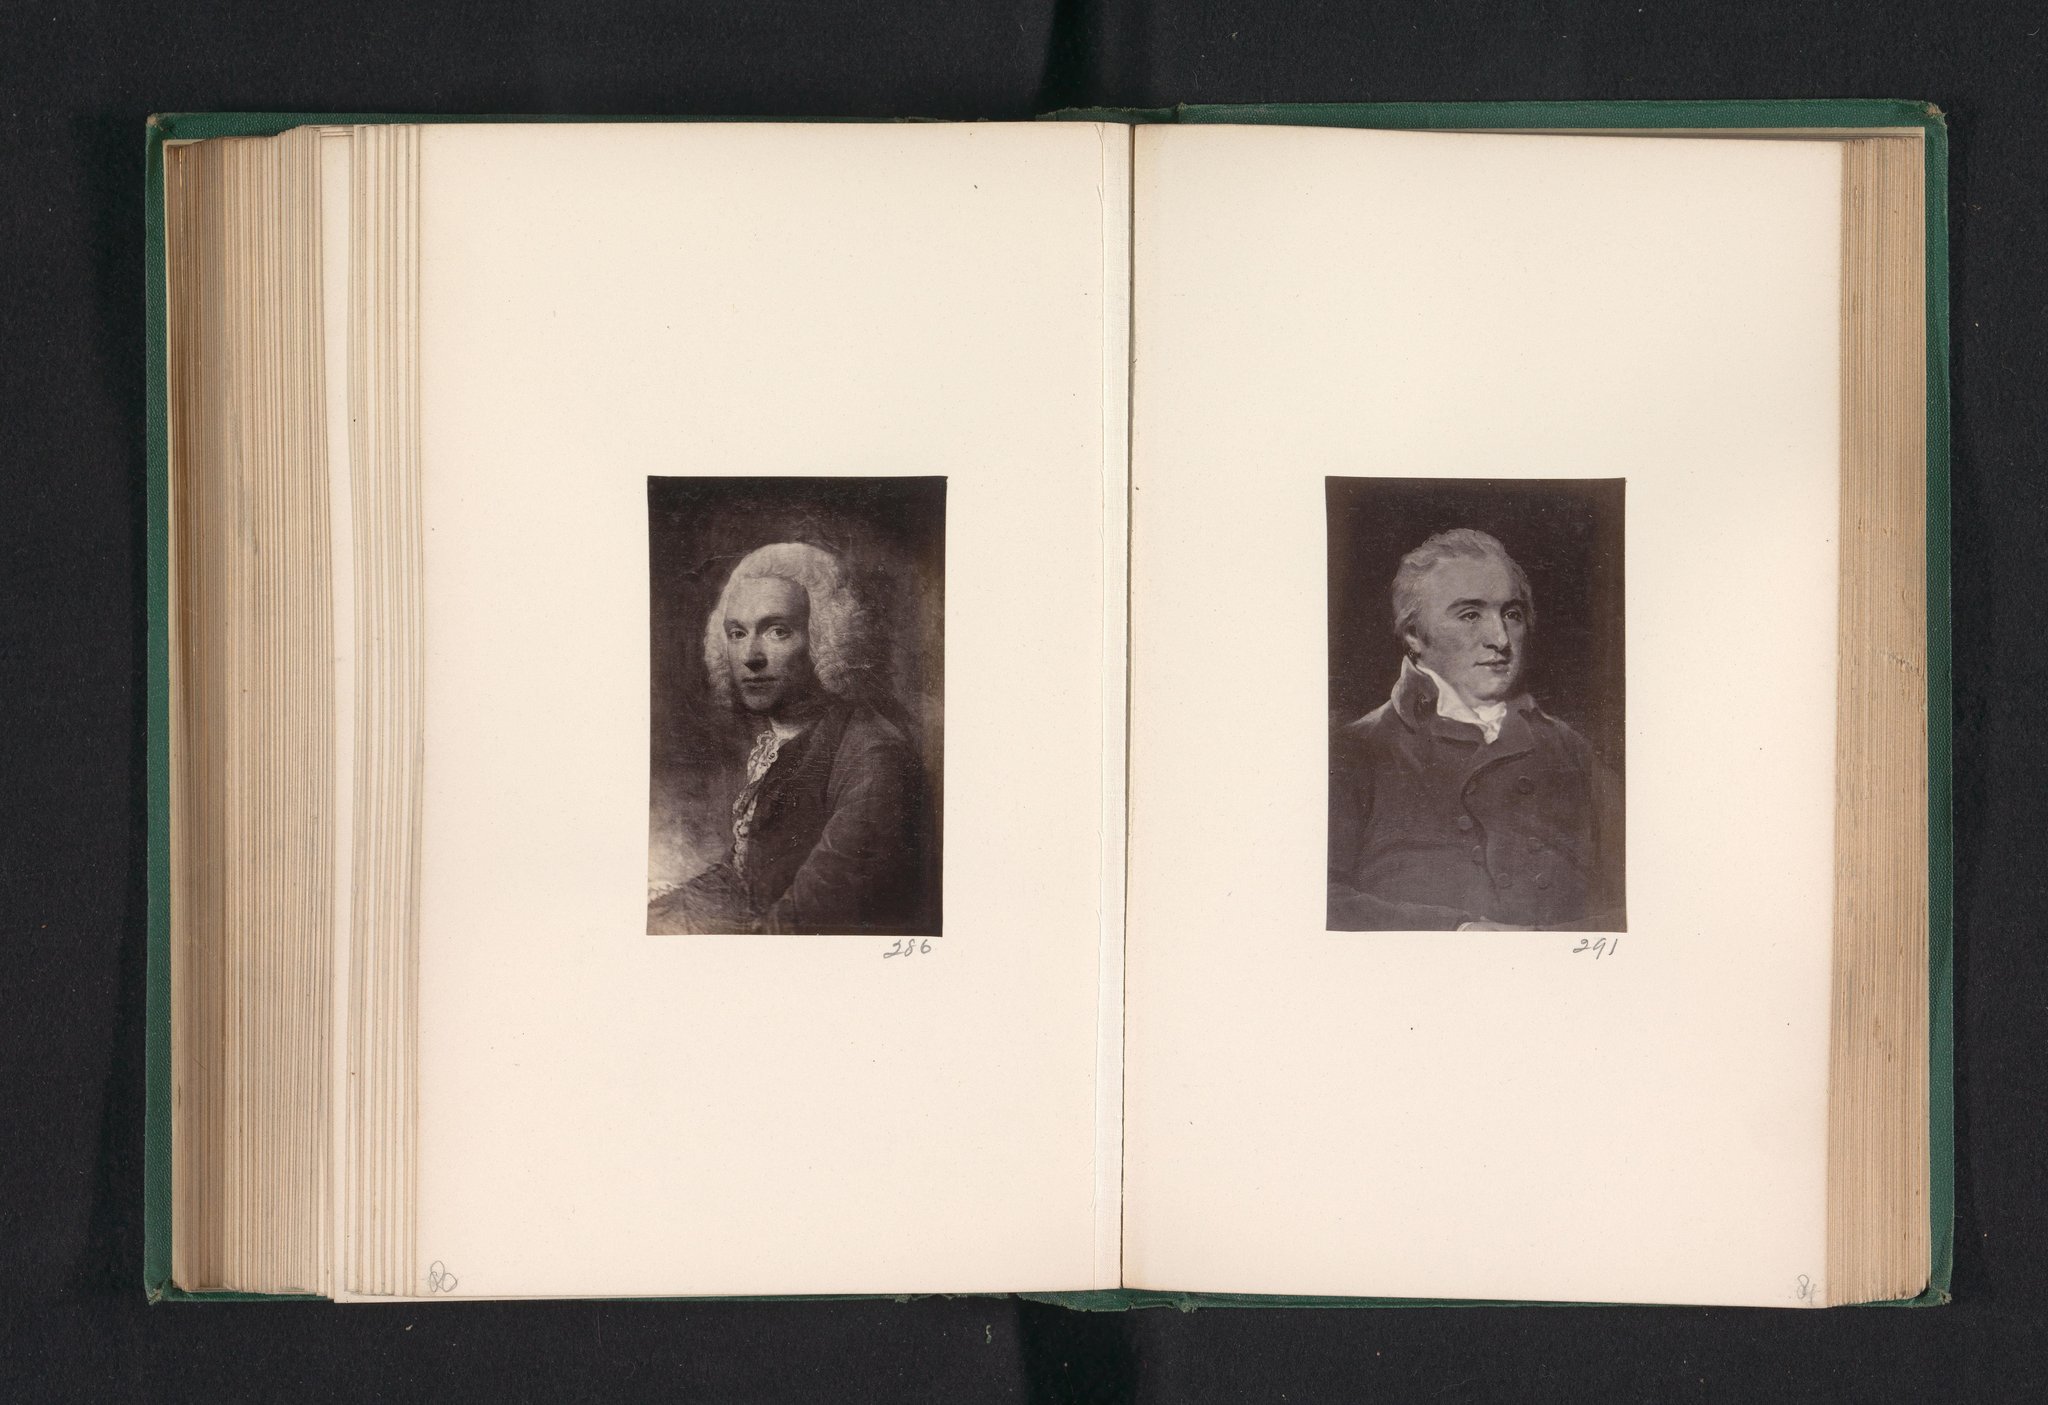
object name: page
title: Fotoreproductie van een schilderij, voorstellende een portret van William Hunter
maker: thomas annan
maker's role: fotograaf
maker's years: 1829-1887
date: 1863-1868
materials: photographic support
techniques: albumen print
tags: historical persons (portraits and scenes from the life) (+ (full) bust portrait)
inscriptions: number: ‘286’